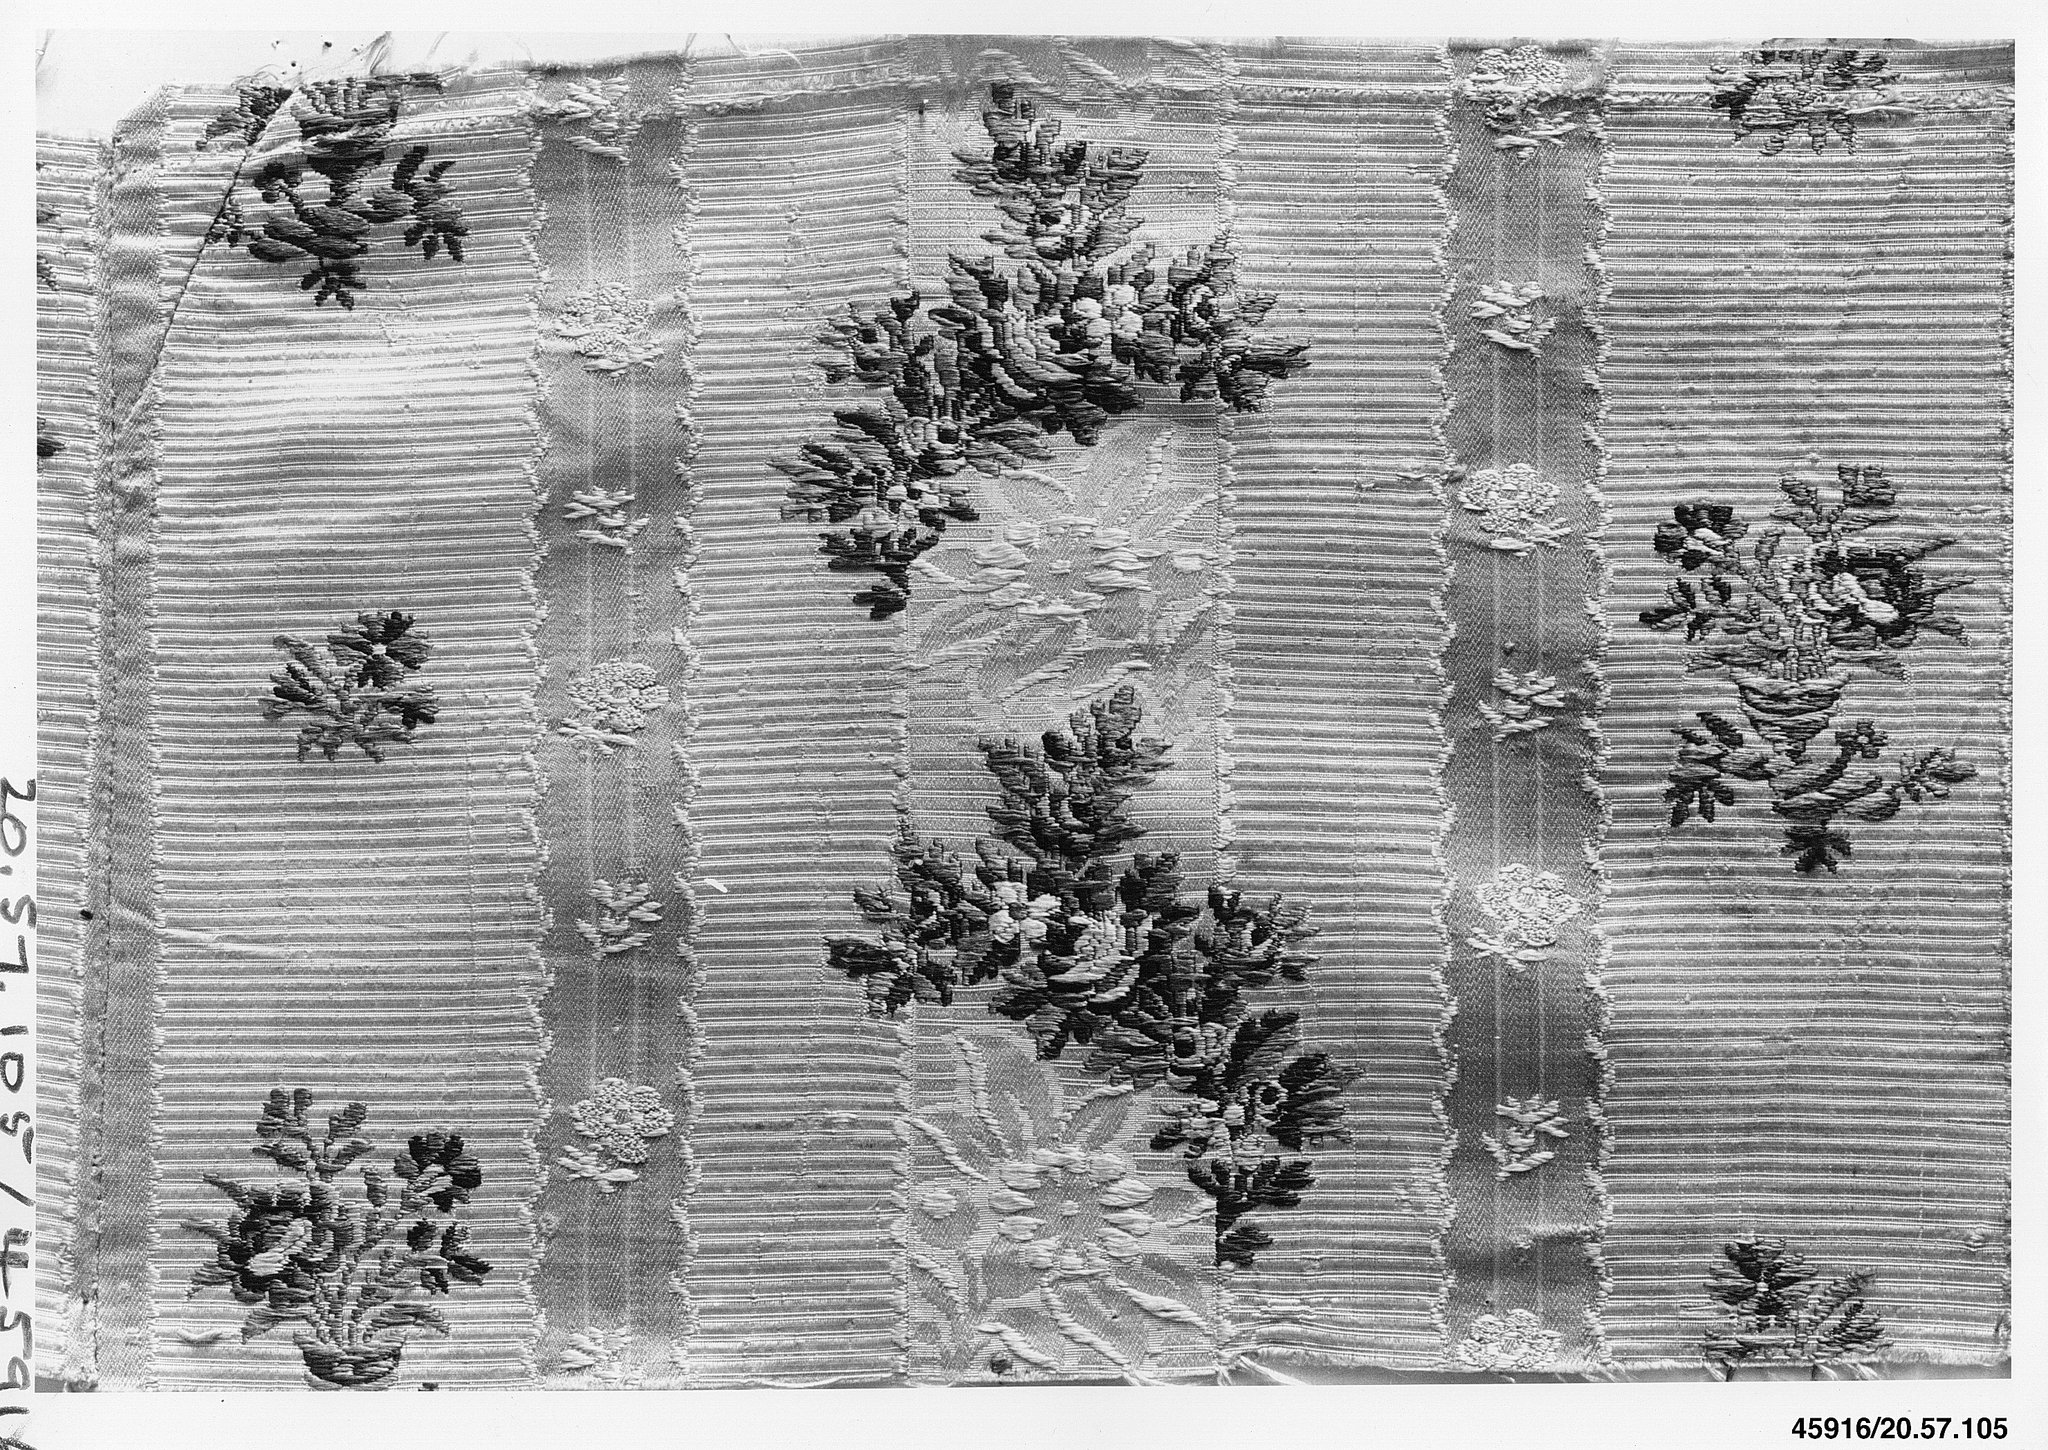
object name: piece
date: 1775-1800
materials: silk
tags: flowers,leaves